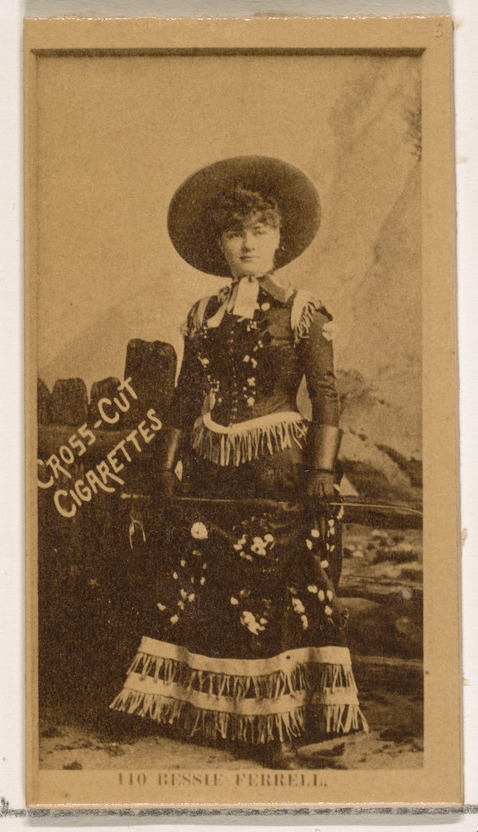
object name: print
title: Card Number 110, Bessie Ferrell, from the Actors and Actresses series (N145-2) issued by Duke Sons & Co. to promote Cross Cut Cigarettes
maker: w. duke, sons & co.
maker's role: publisher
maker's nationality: american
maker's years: 1870-1920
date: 1880-1889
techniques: albumen silver print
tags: portraits,women,actresses